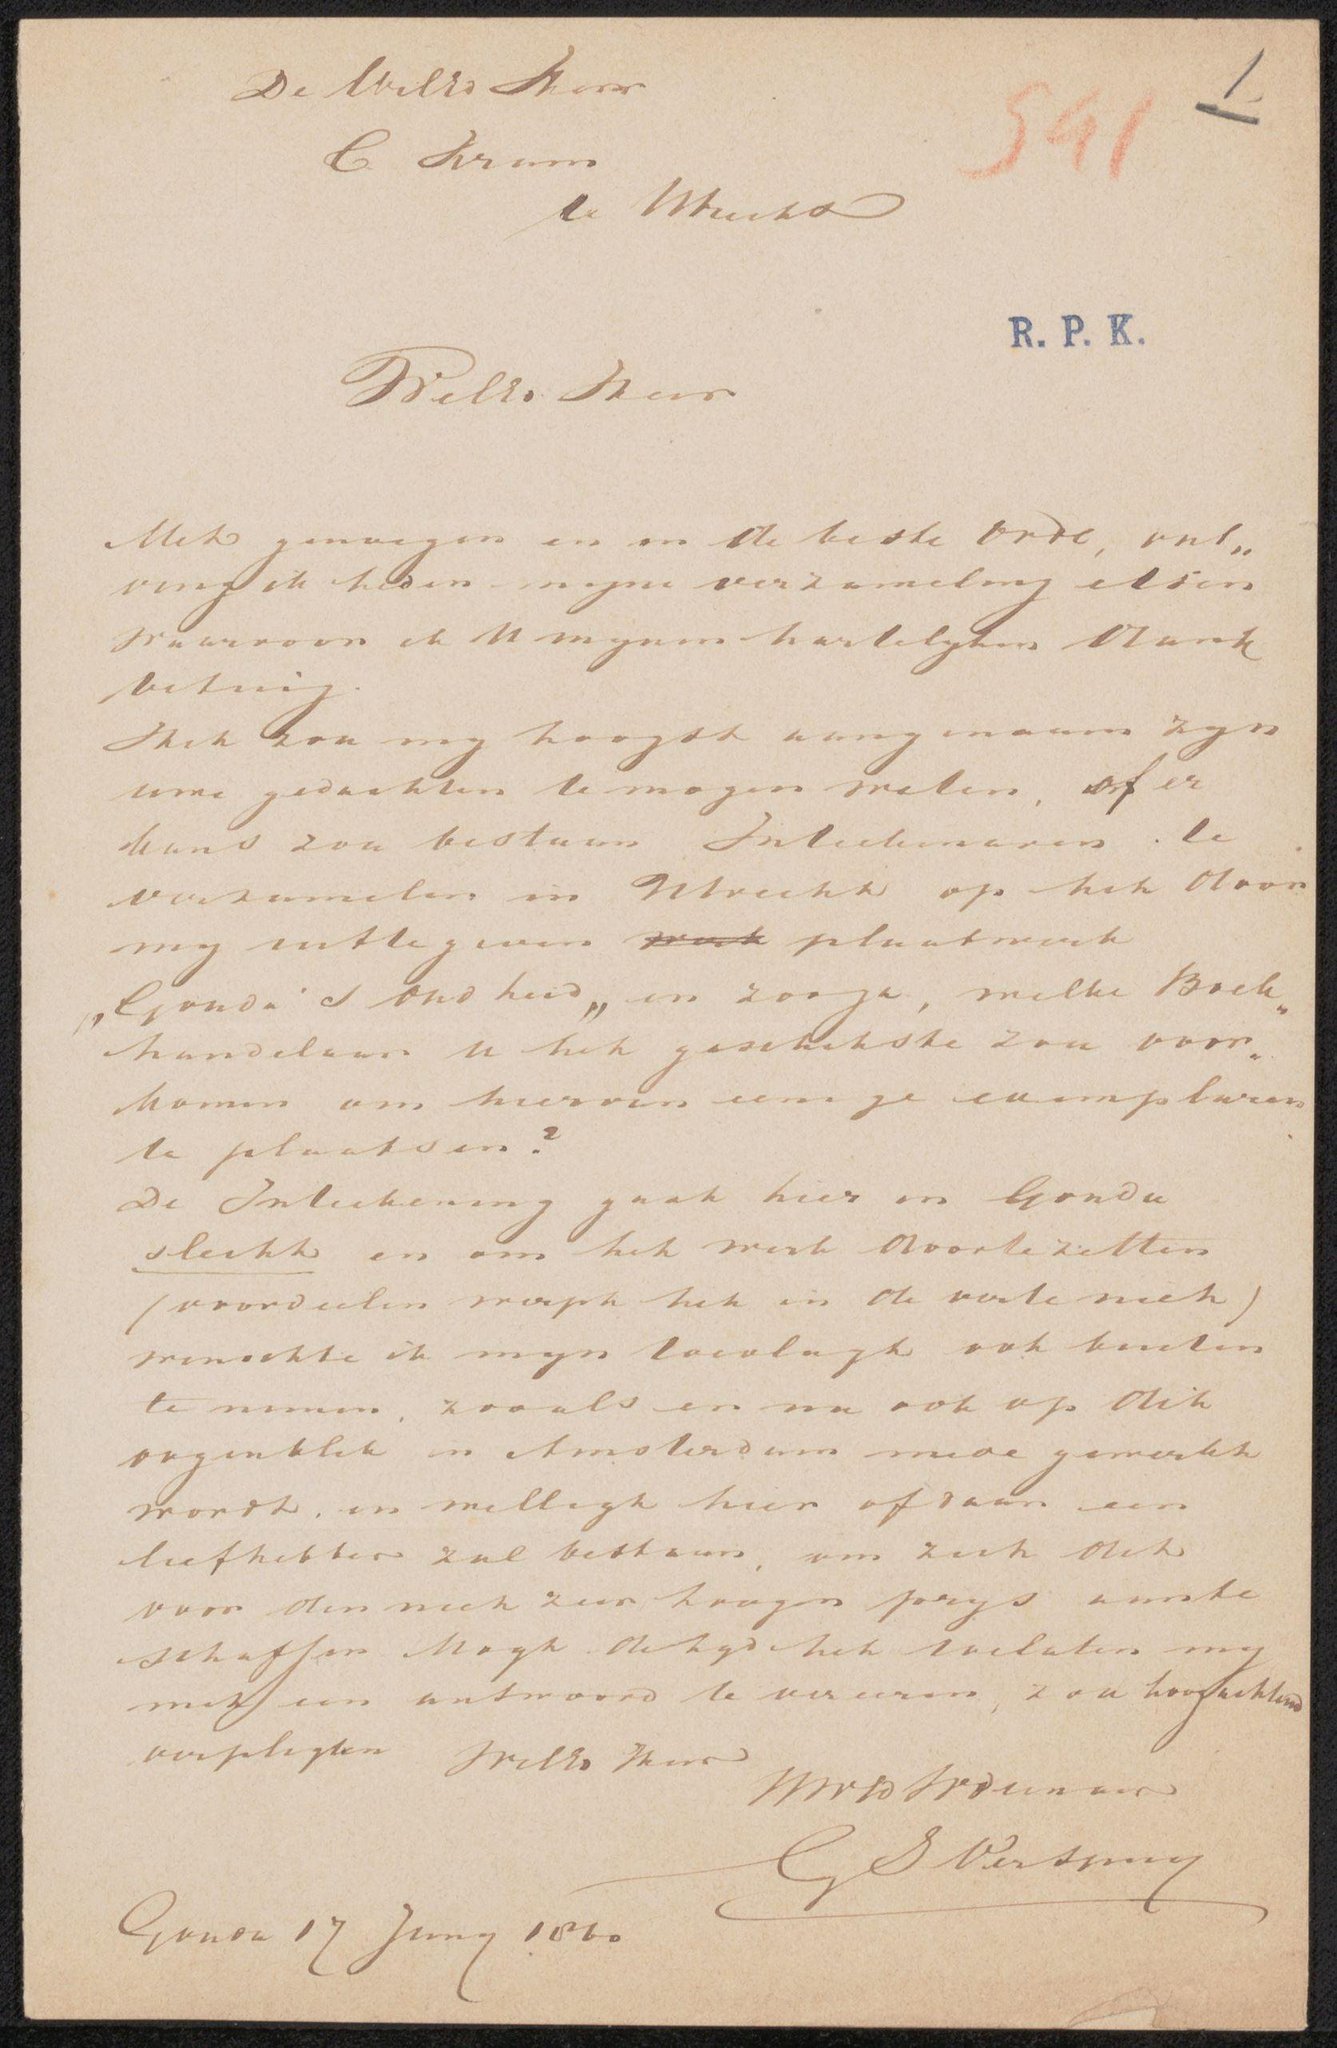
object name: letter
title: Brief aan Christiaan Kramm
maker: gijsbertus johannes verspuy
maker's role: print maker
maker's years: 1823-1862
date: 1860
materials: ink, paper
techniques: pen, writing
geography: gouda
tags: utrecht, print maker, draughtsman, christiaan kramm, drawing, the graphic arts, printed matter, gouda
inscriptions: collector's mark: Lugt 2233